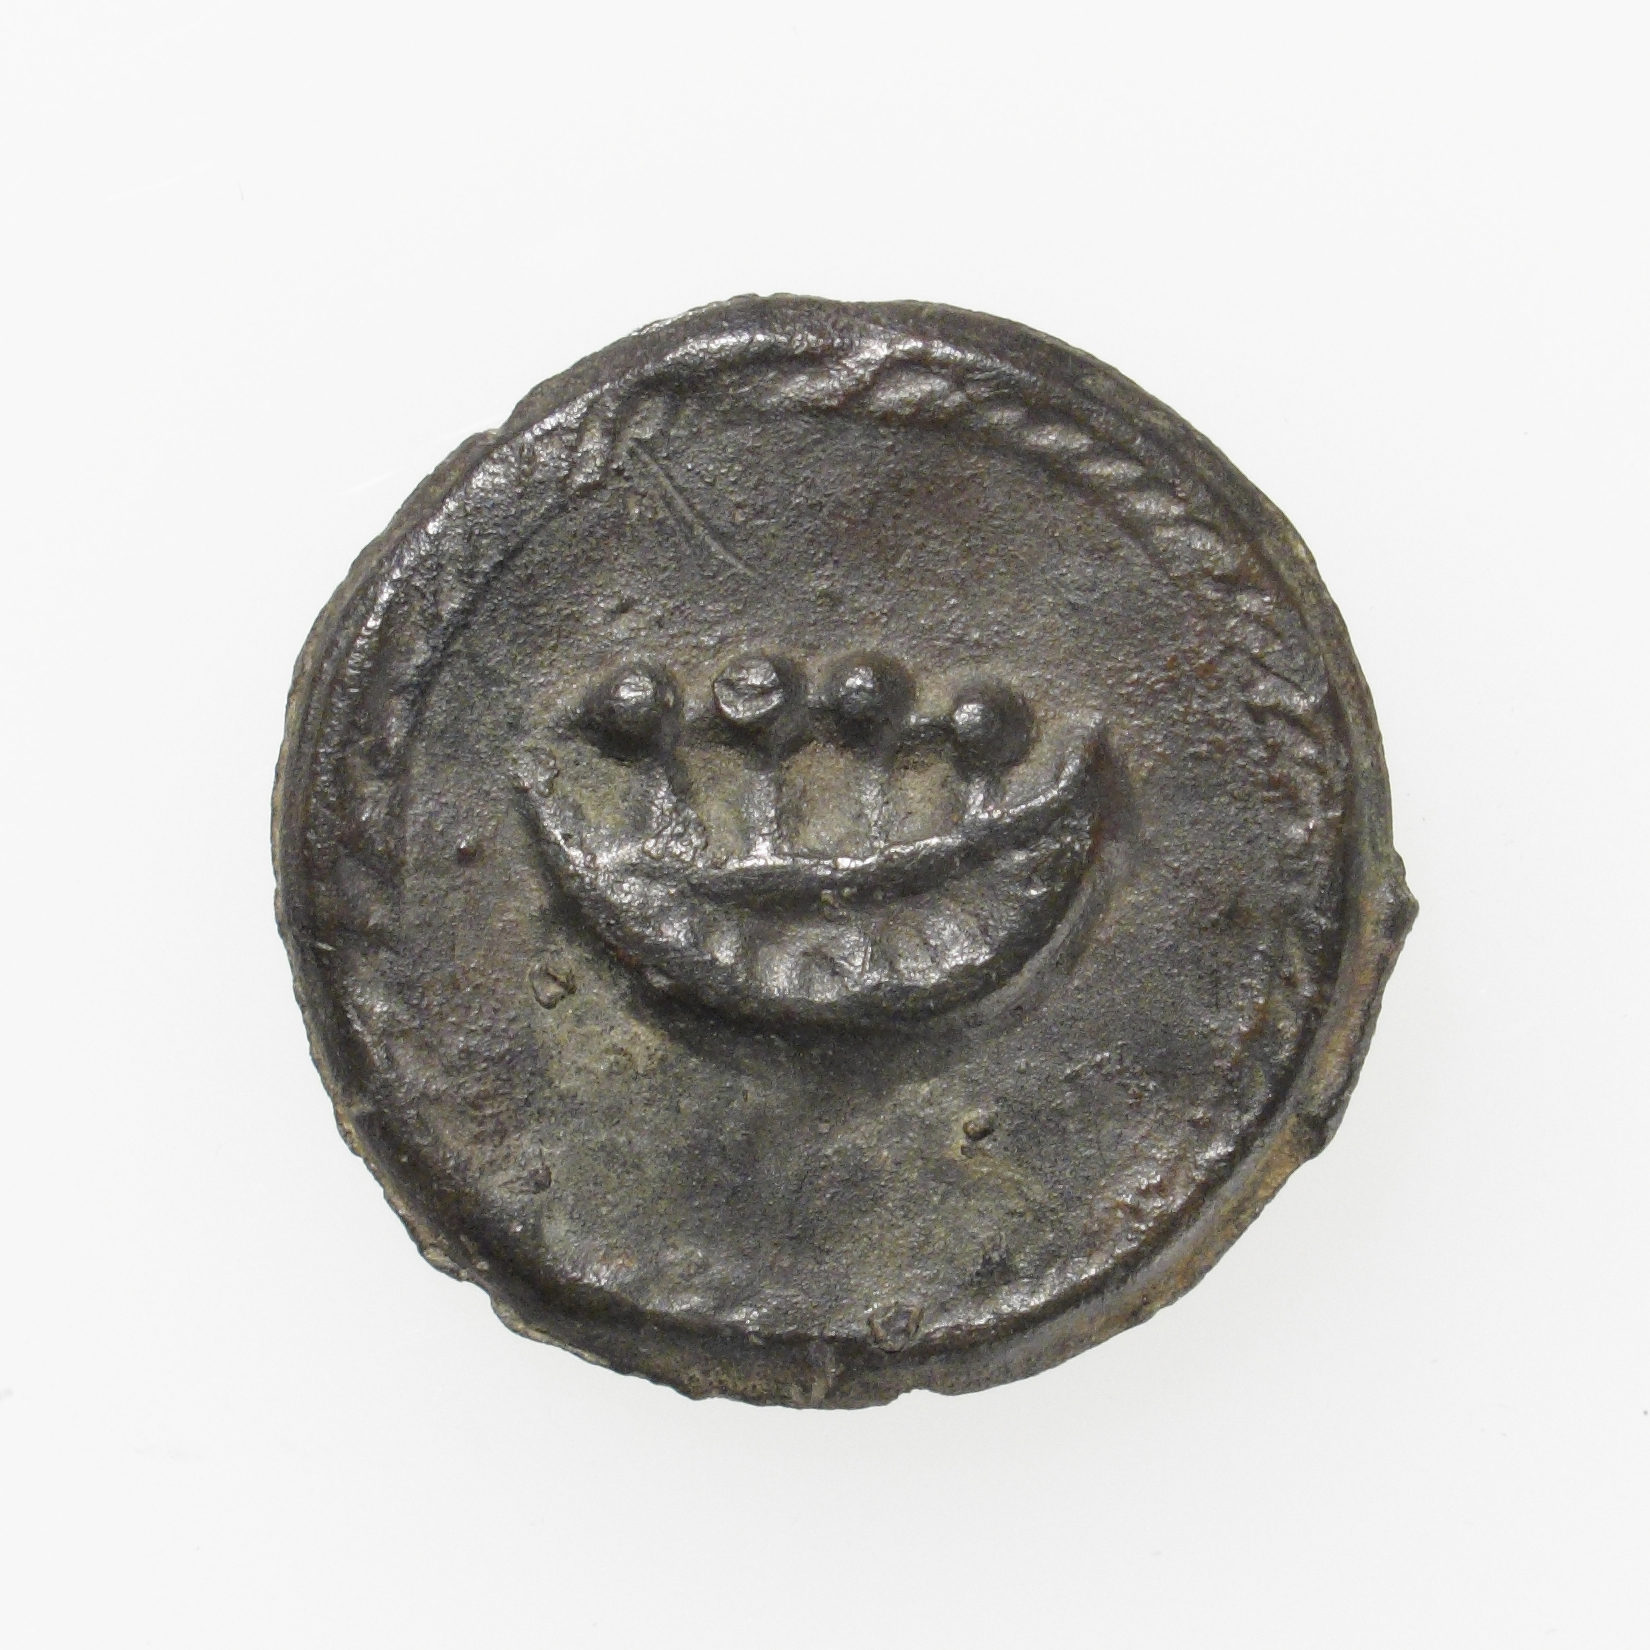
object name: pilgrim's badge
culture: french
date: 1301-1600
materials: lead